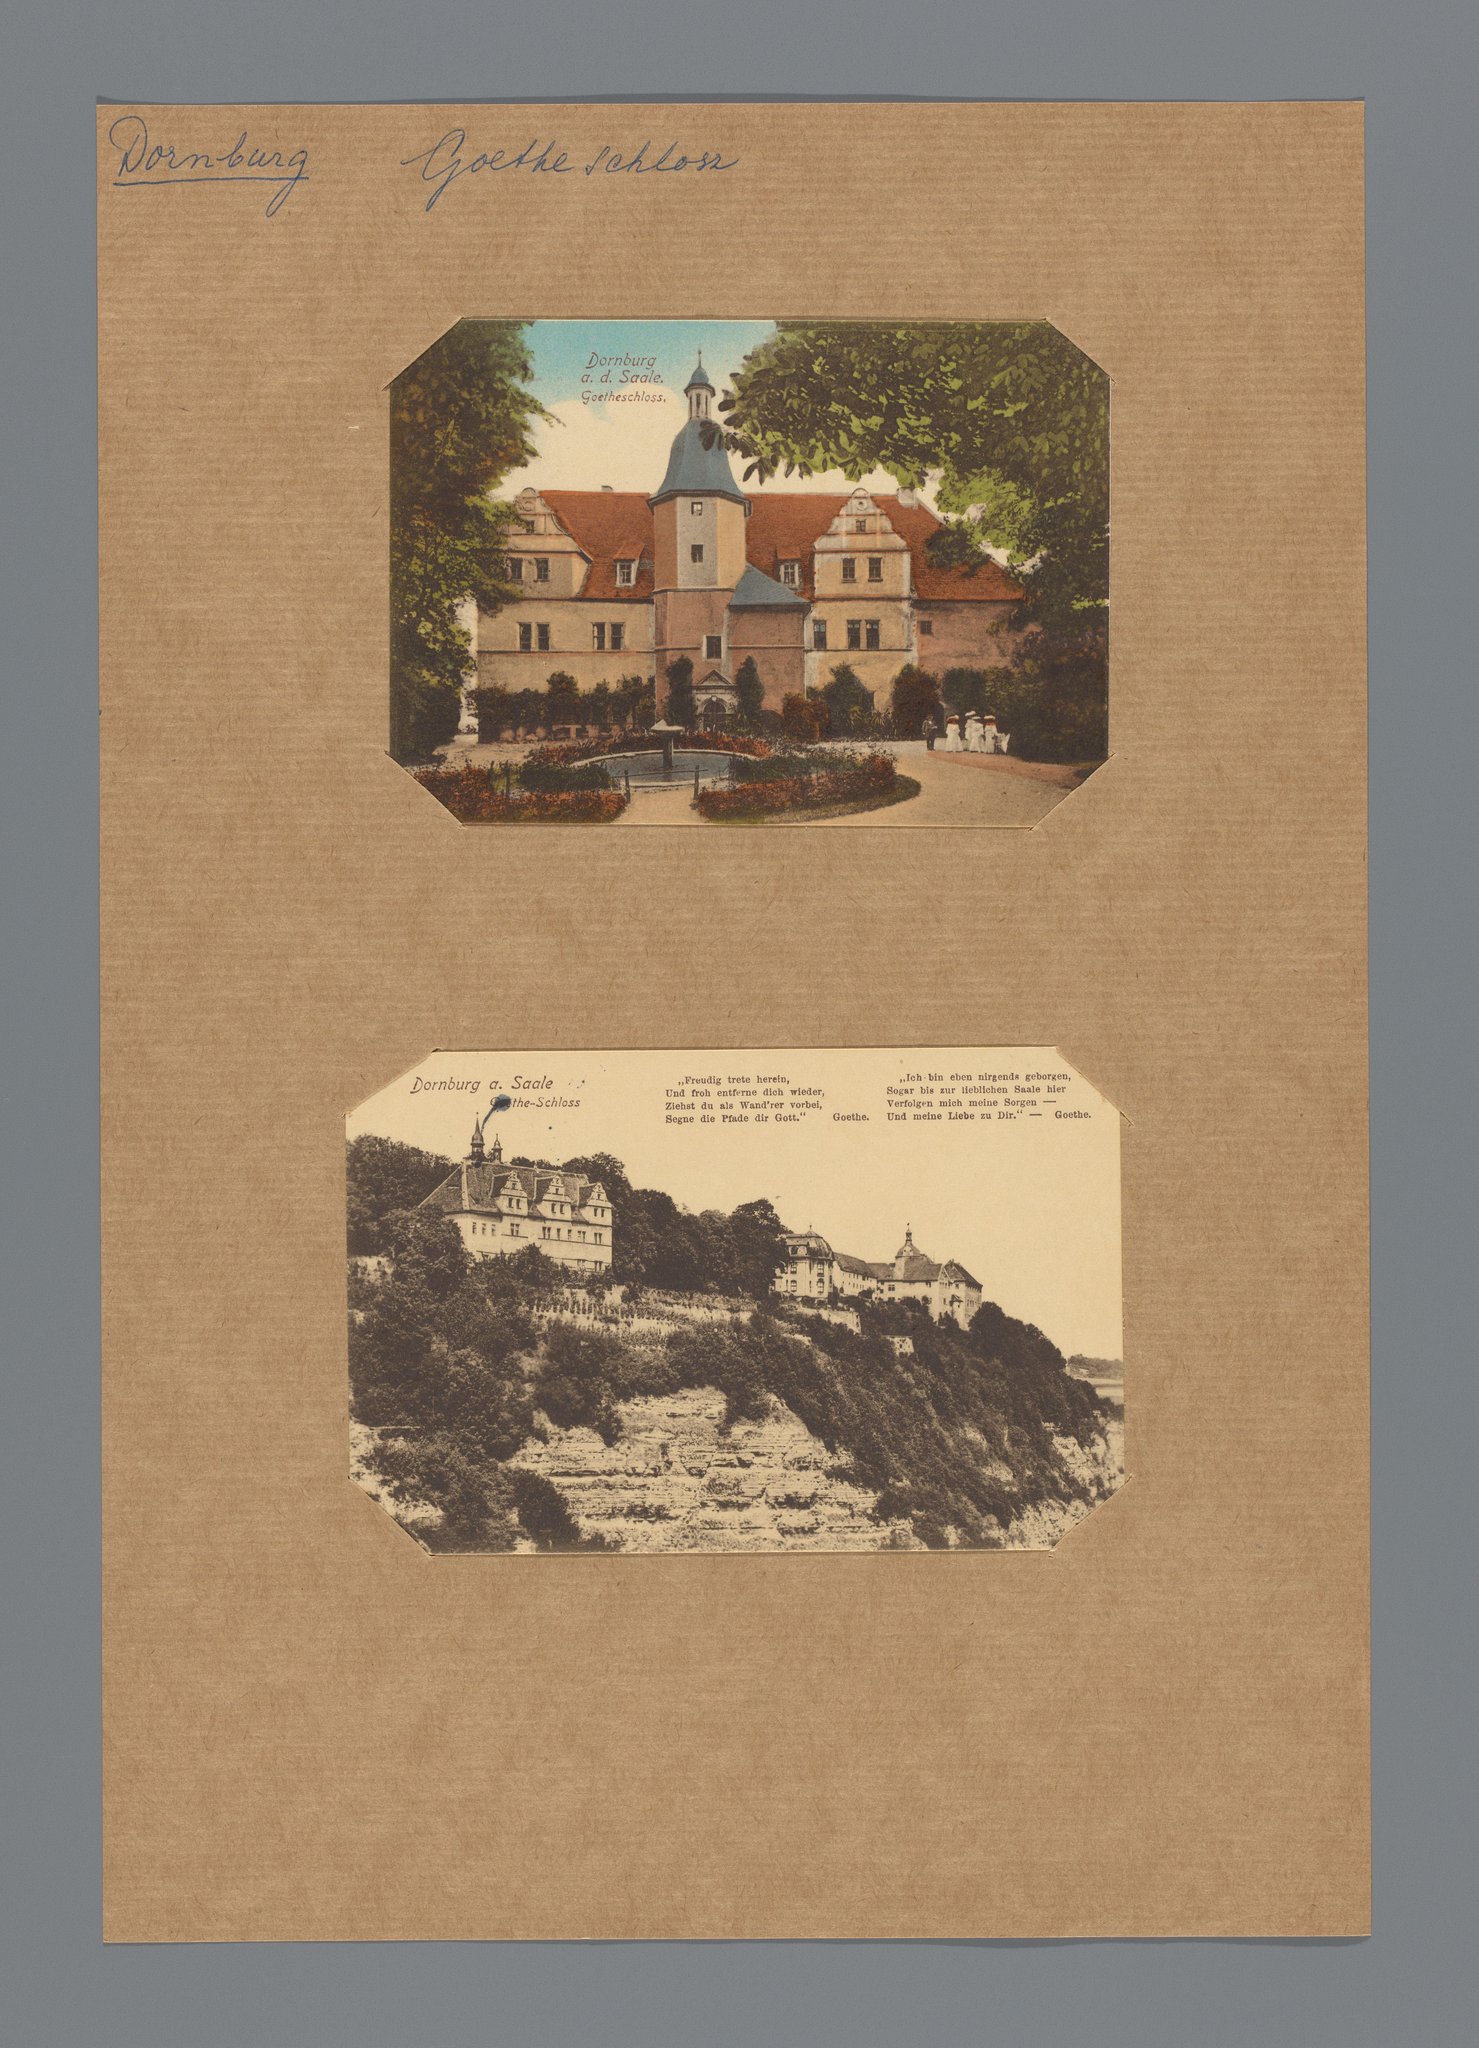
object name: photograph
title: Dornburg a.d. Saale Goetheschloss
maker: Anonymous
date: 1880-1920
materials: paper, photographic support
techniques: photograph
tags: germany